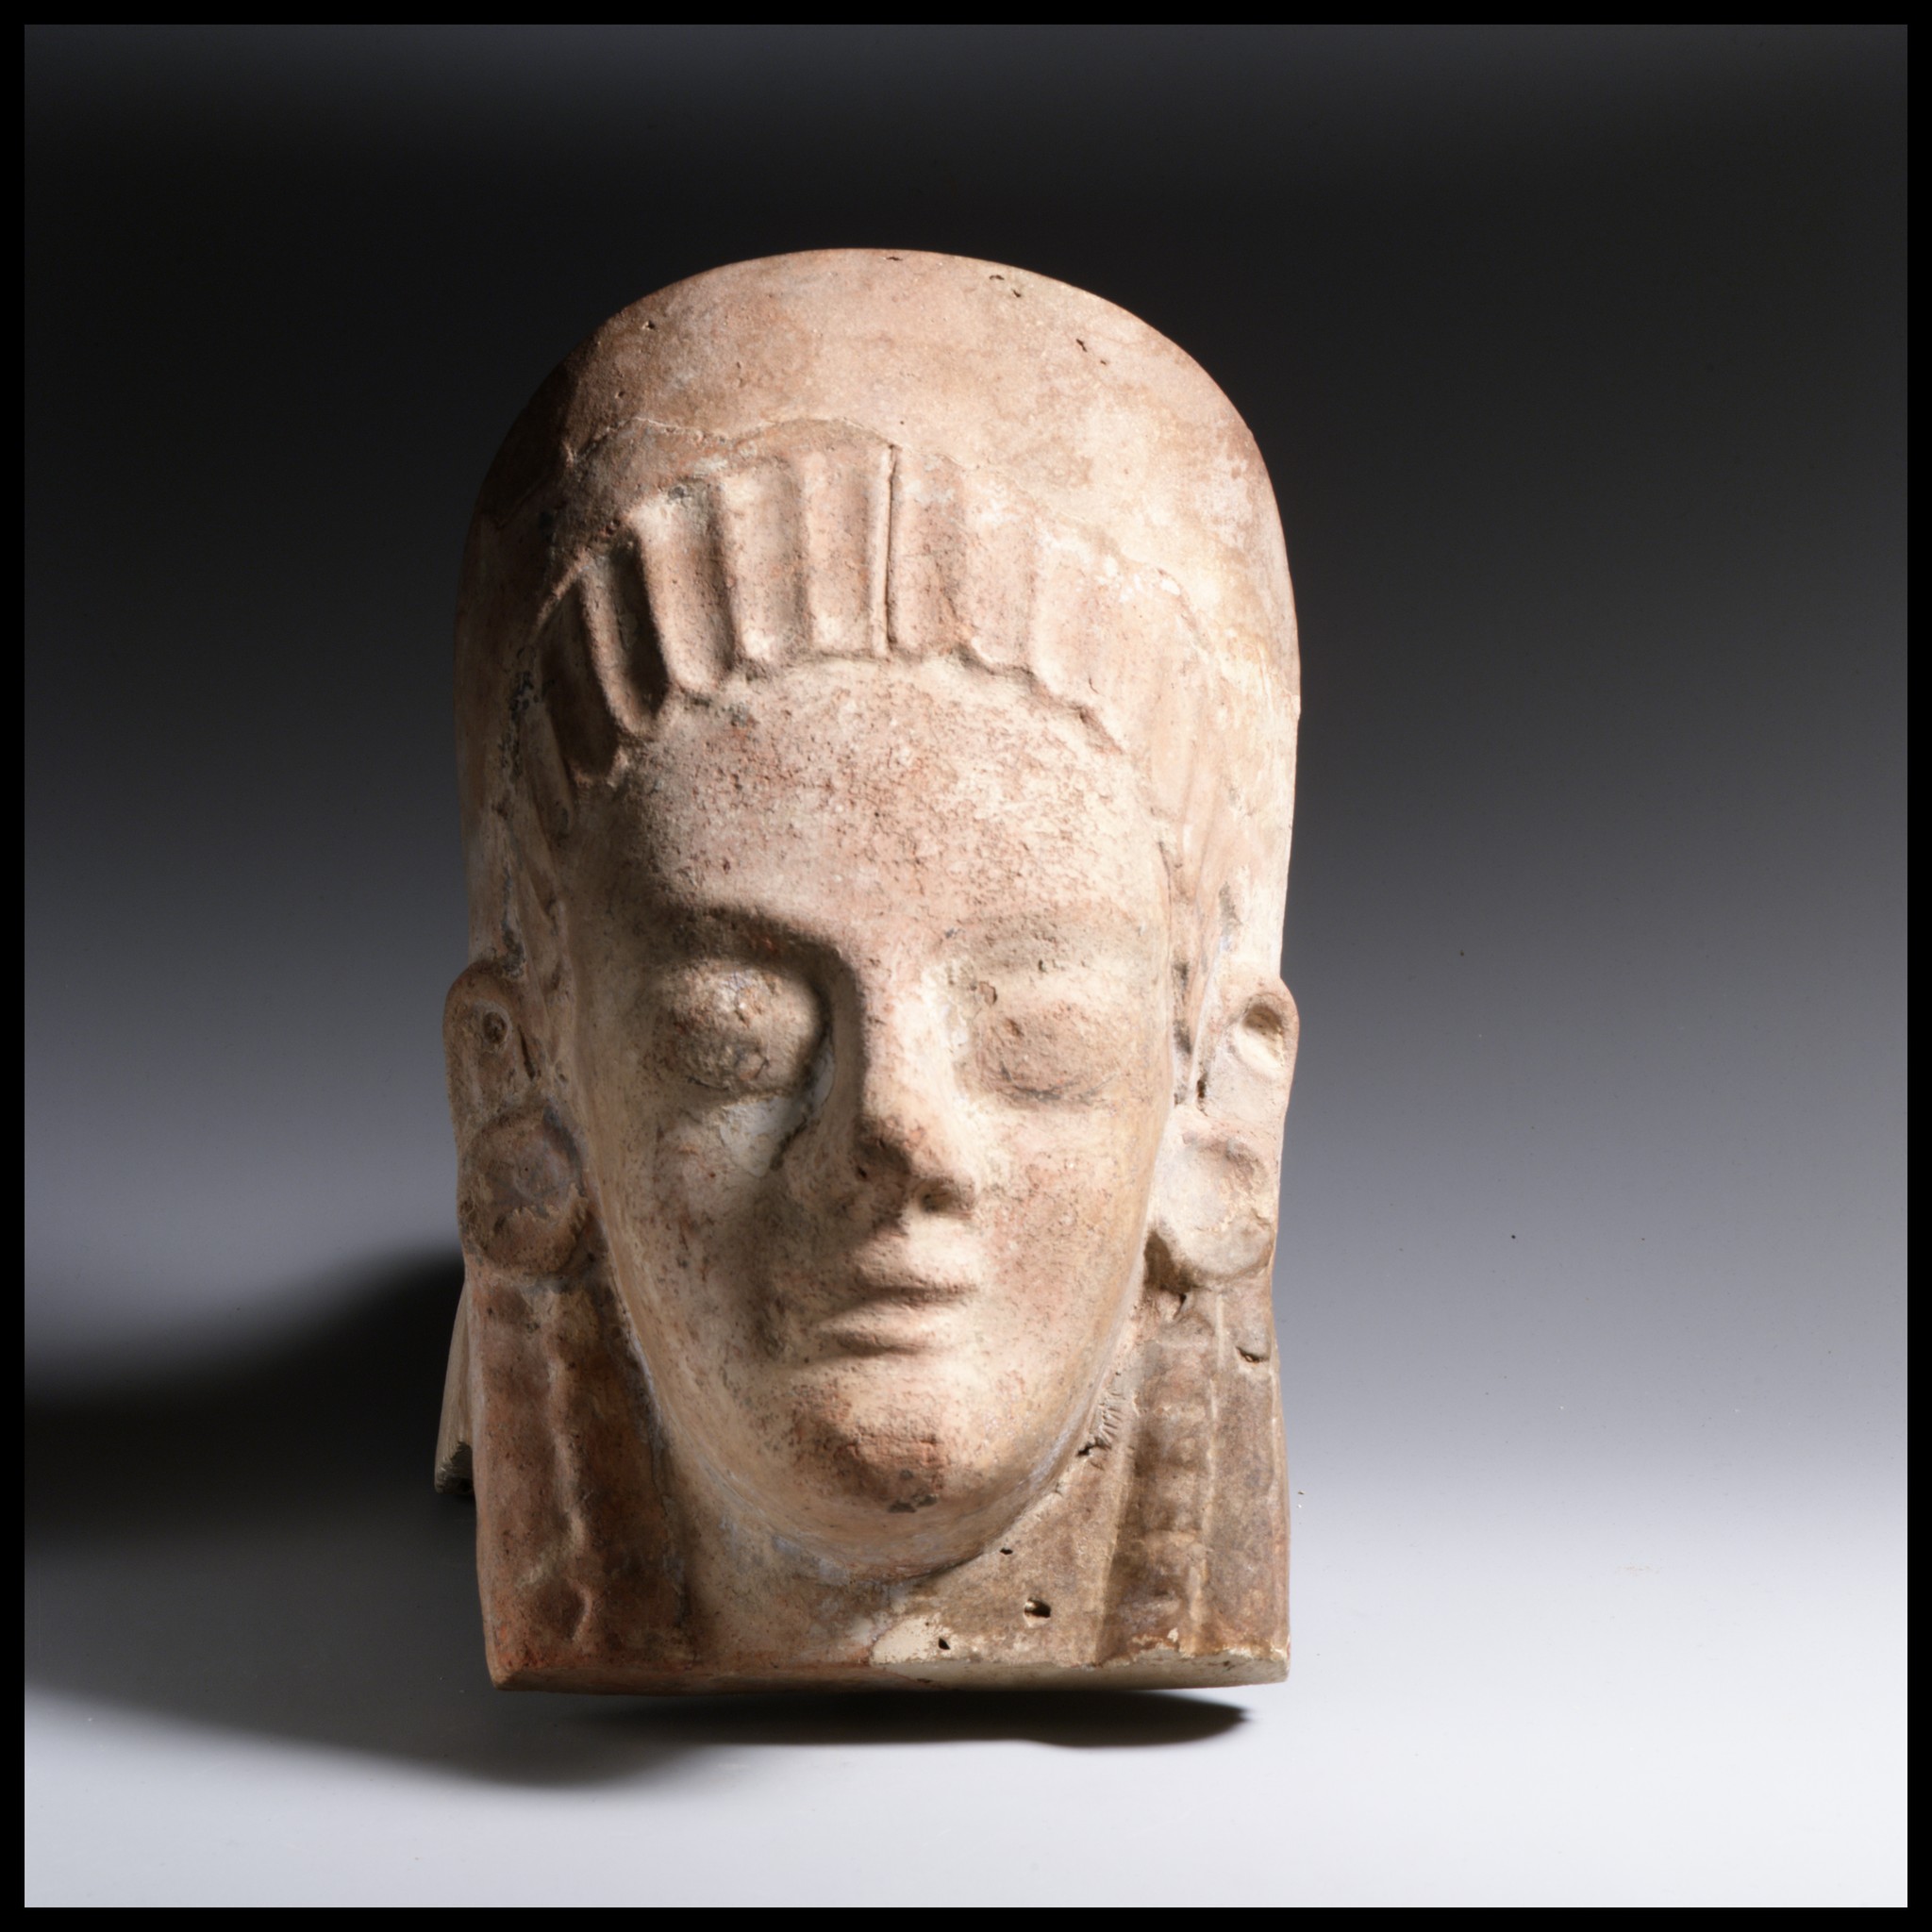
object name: antefix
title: Terracotta antefix (roof tile) with head of a woman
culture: etruscan, cerveteri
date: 500-468 BCE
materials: terracotta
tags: heads,women